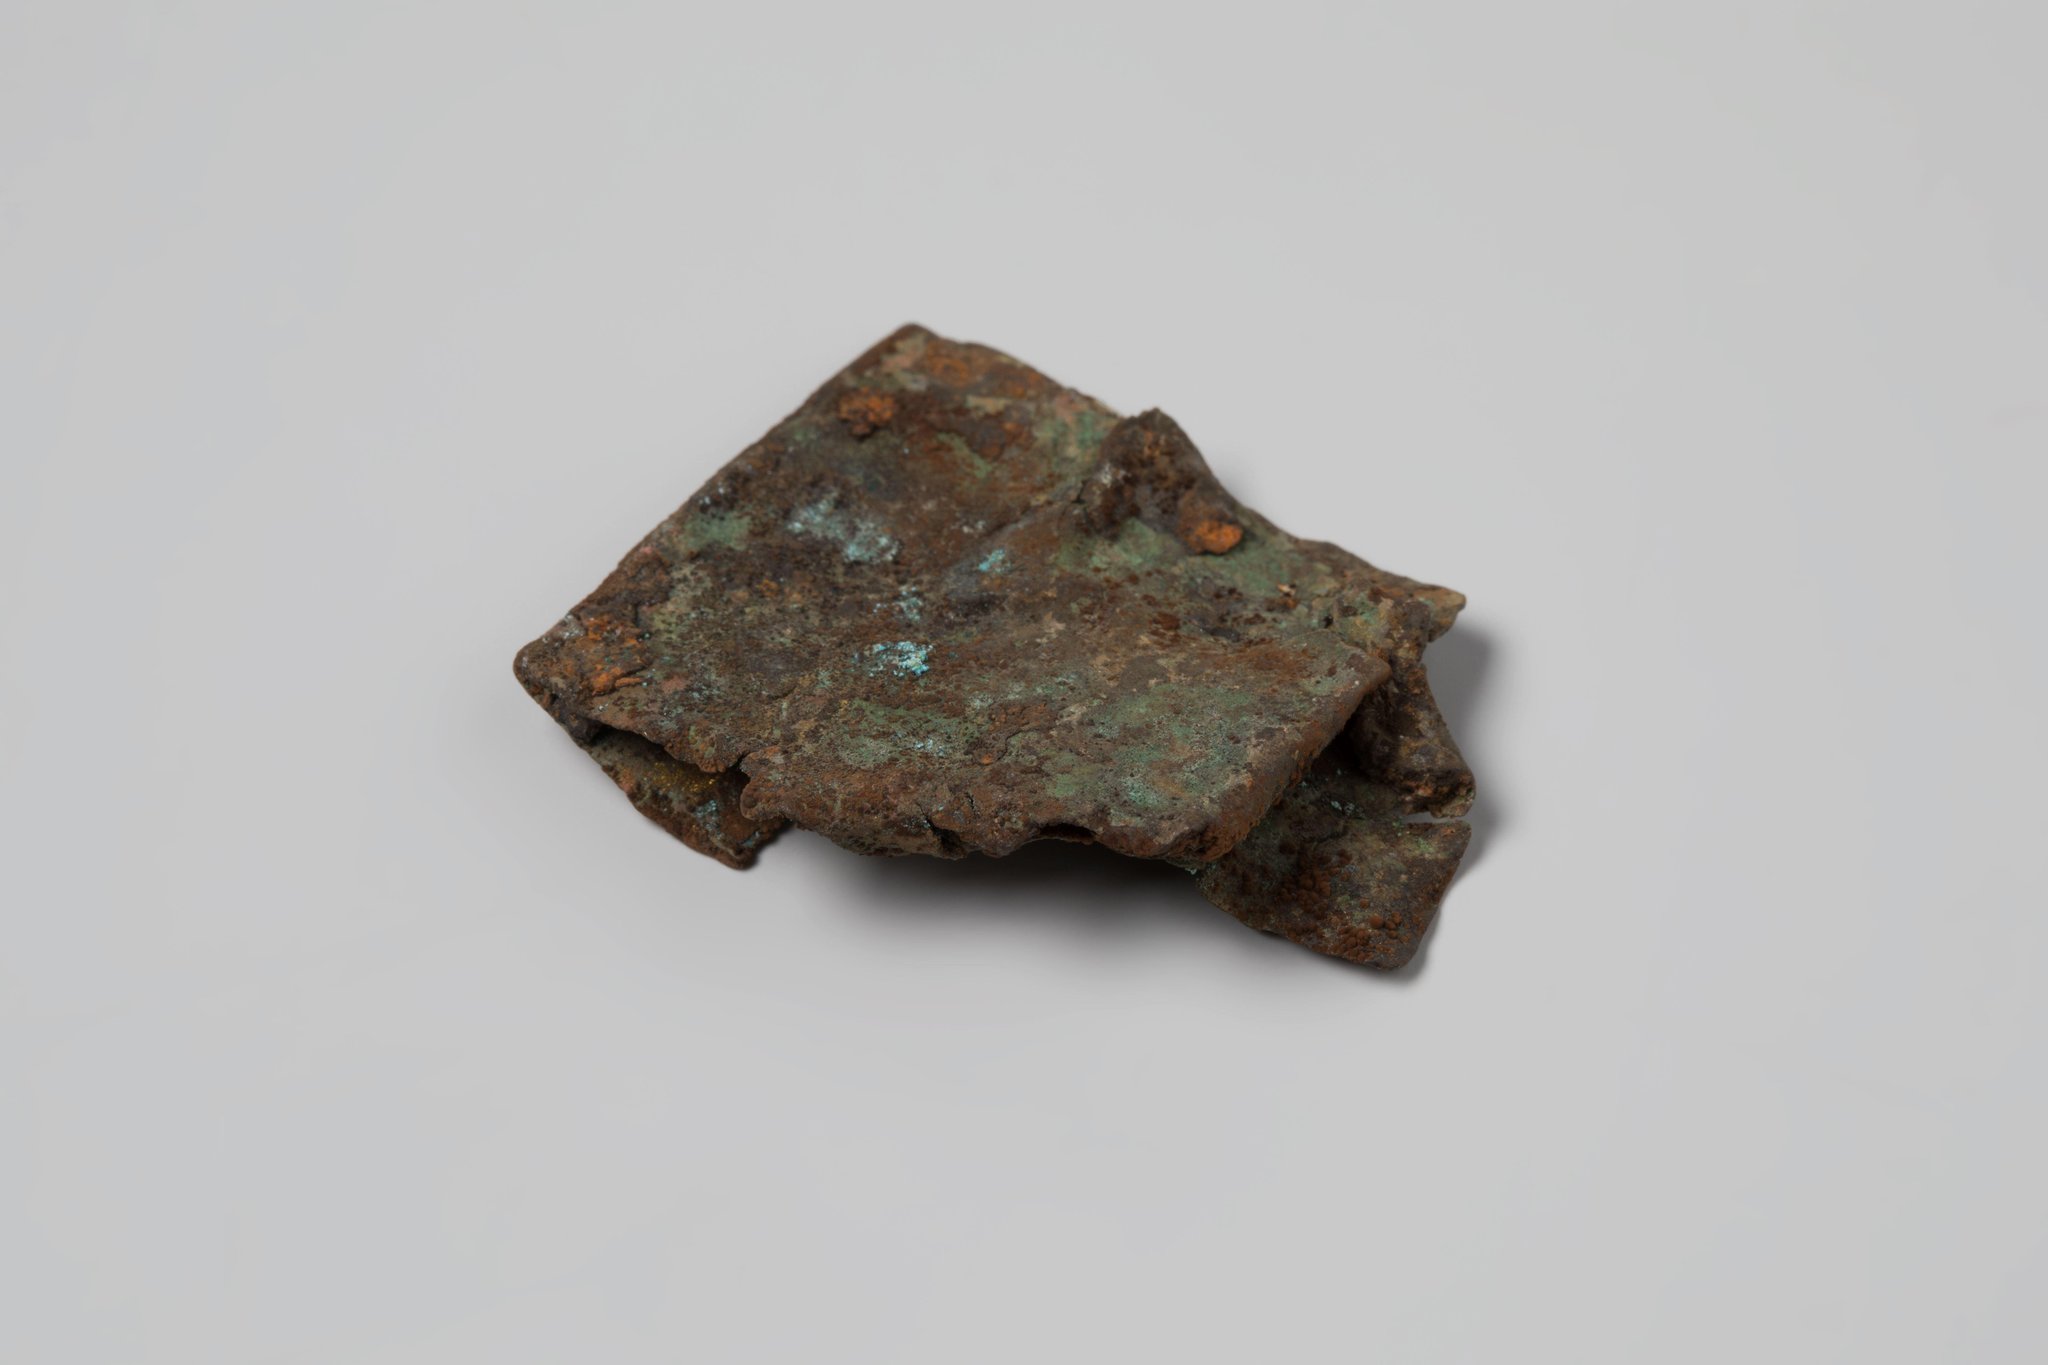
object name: beslag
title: Beslag uit het wrak van de Oost-Indiëvaarder Hollandia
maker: Anonymous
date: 1700-1743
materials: copper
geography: netherlands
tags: verenigde oostindische compagnie, hollandia (schip), annet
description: Fittings, bands and bracing, flat; fragm, one end broken, sim. NG 1980-27H3053.